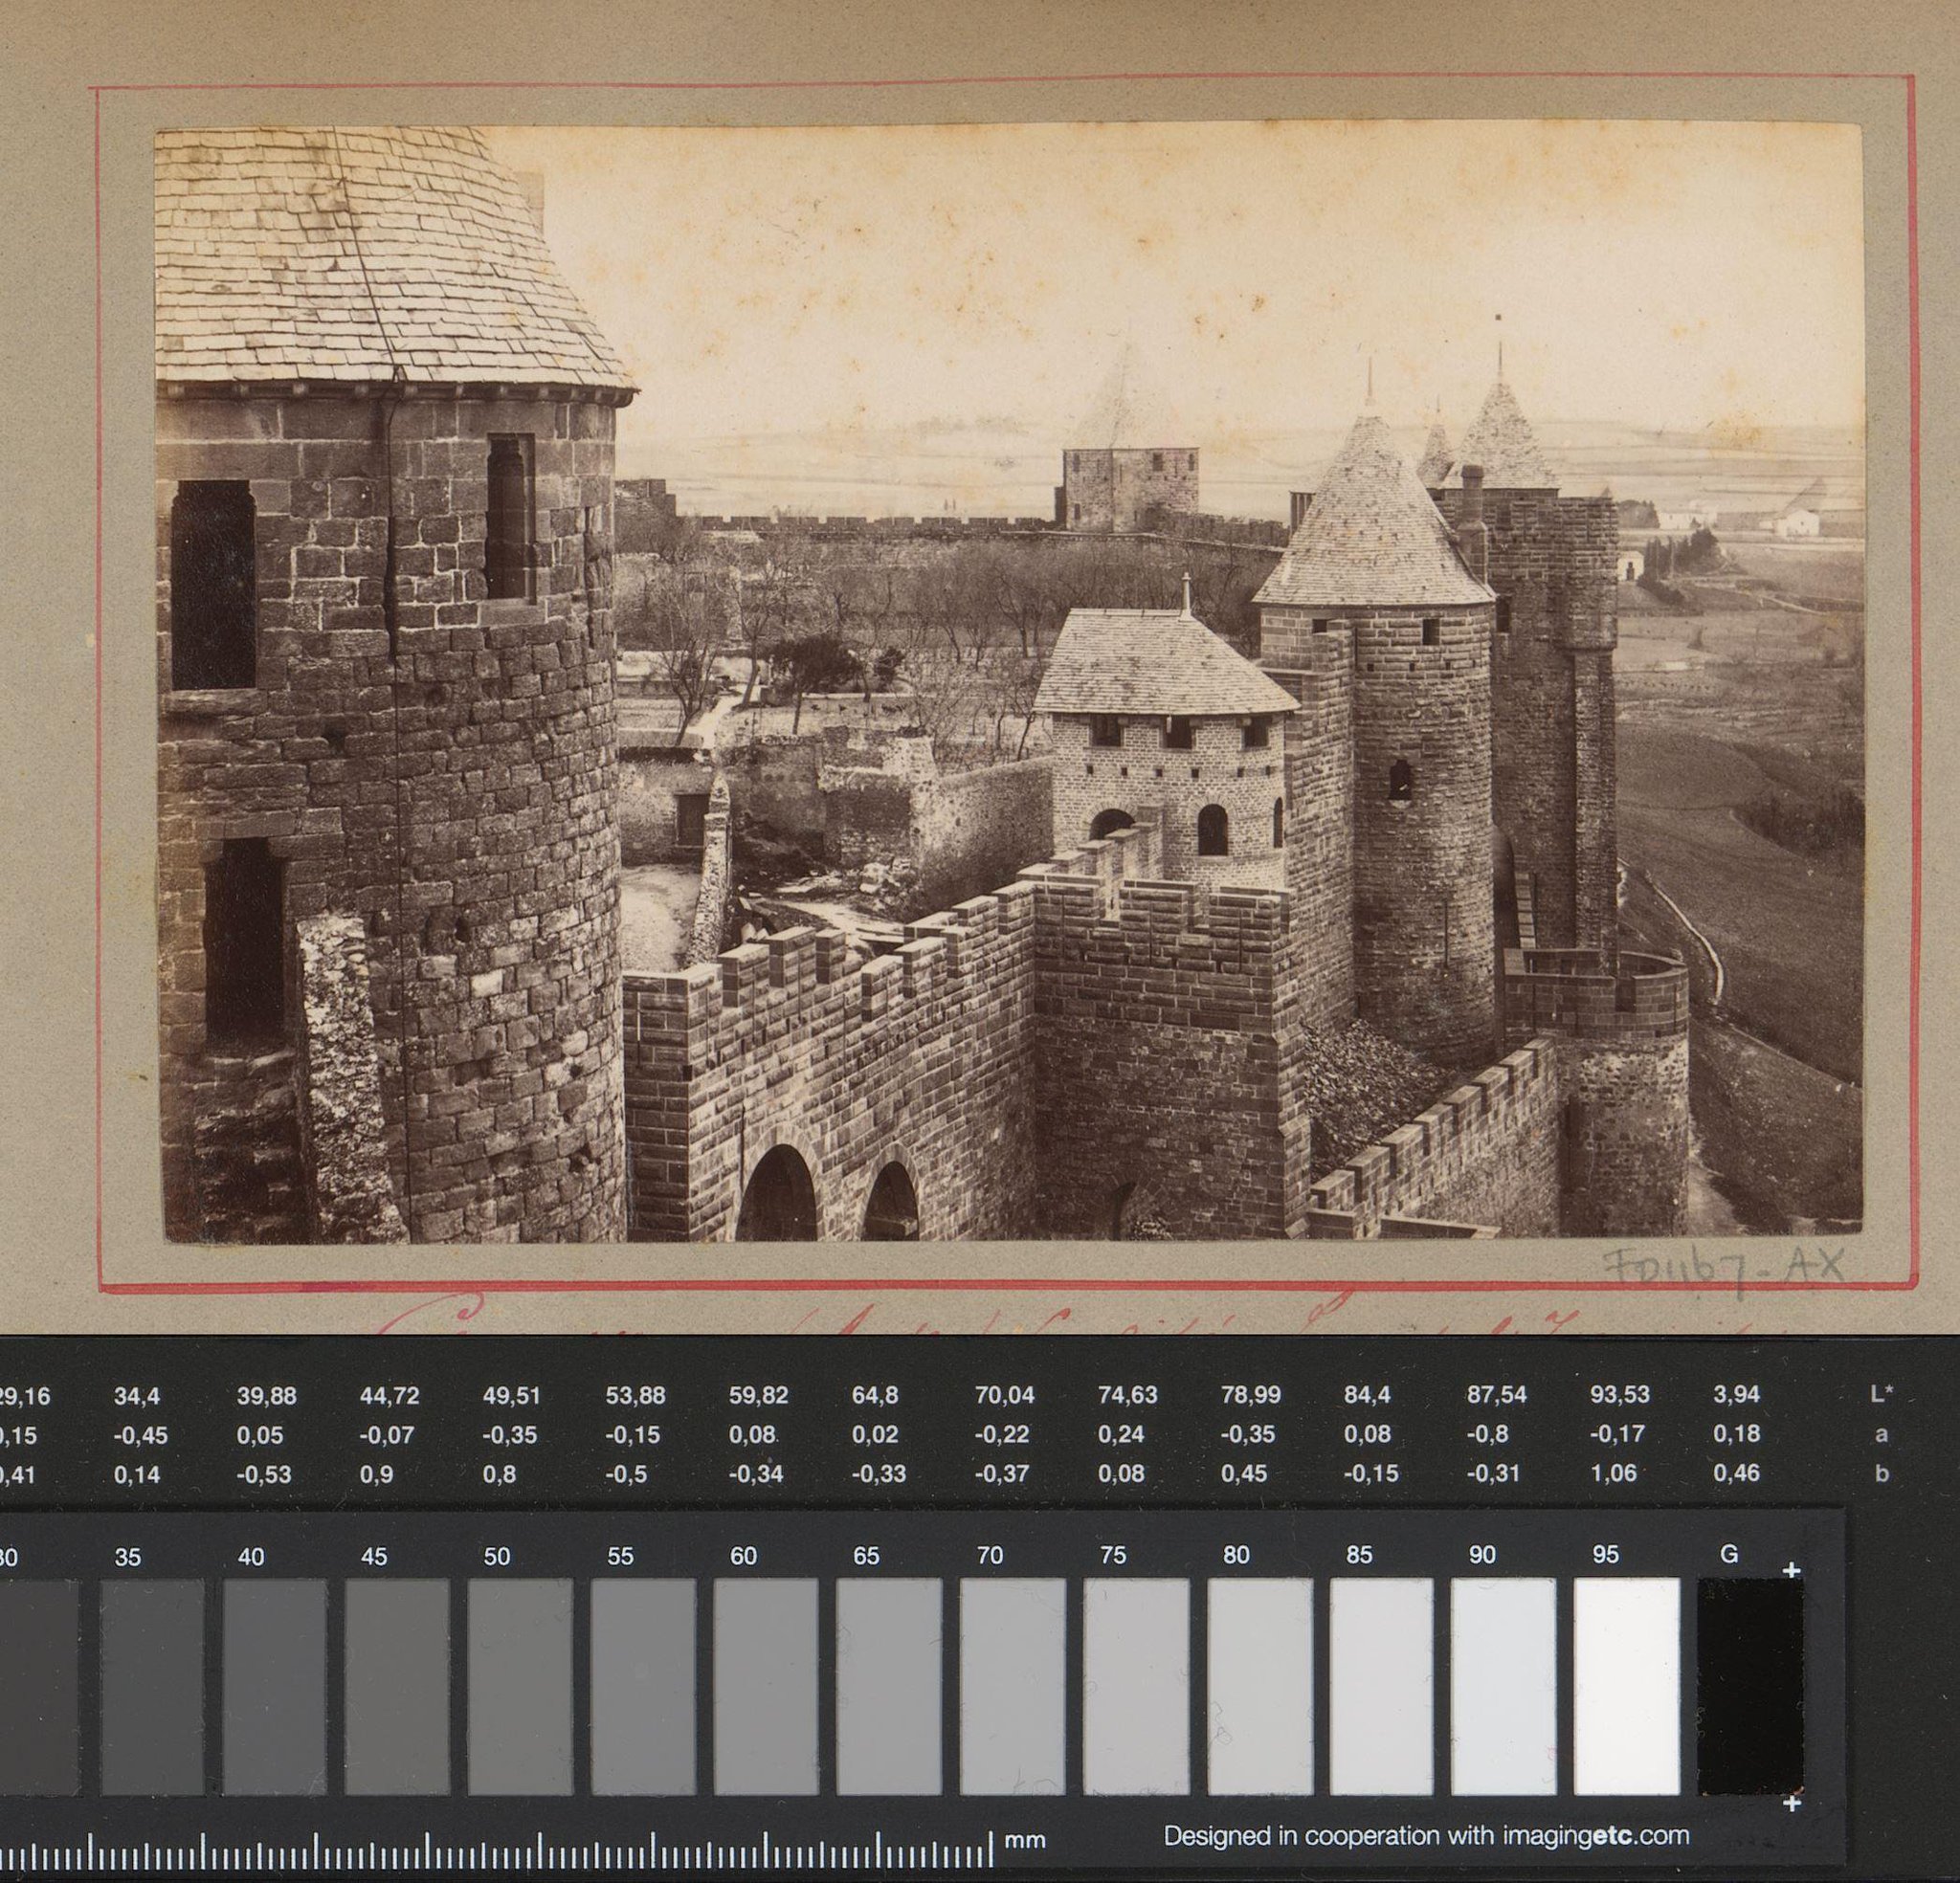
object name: photograph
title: Torens van Cité de Carcassonne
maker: Anonymous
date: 1880-1910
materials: photographic support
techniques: albumen print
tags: towers ~ fortified city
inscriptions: annotation: ‘Carcassonne [..] La Cité. Cour de l'inquisition’